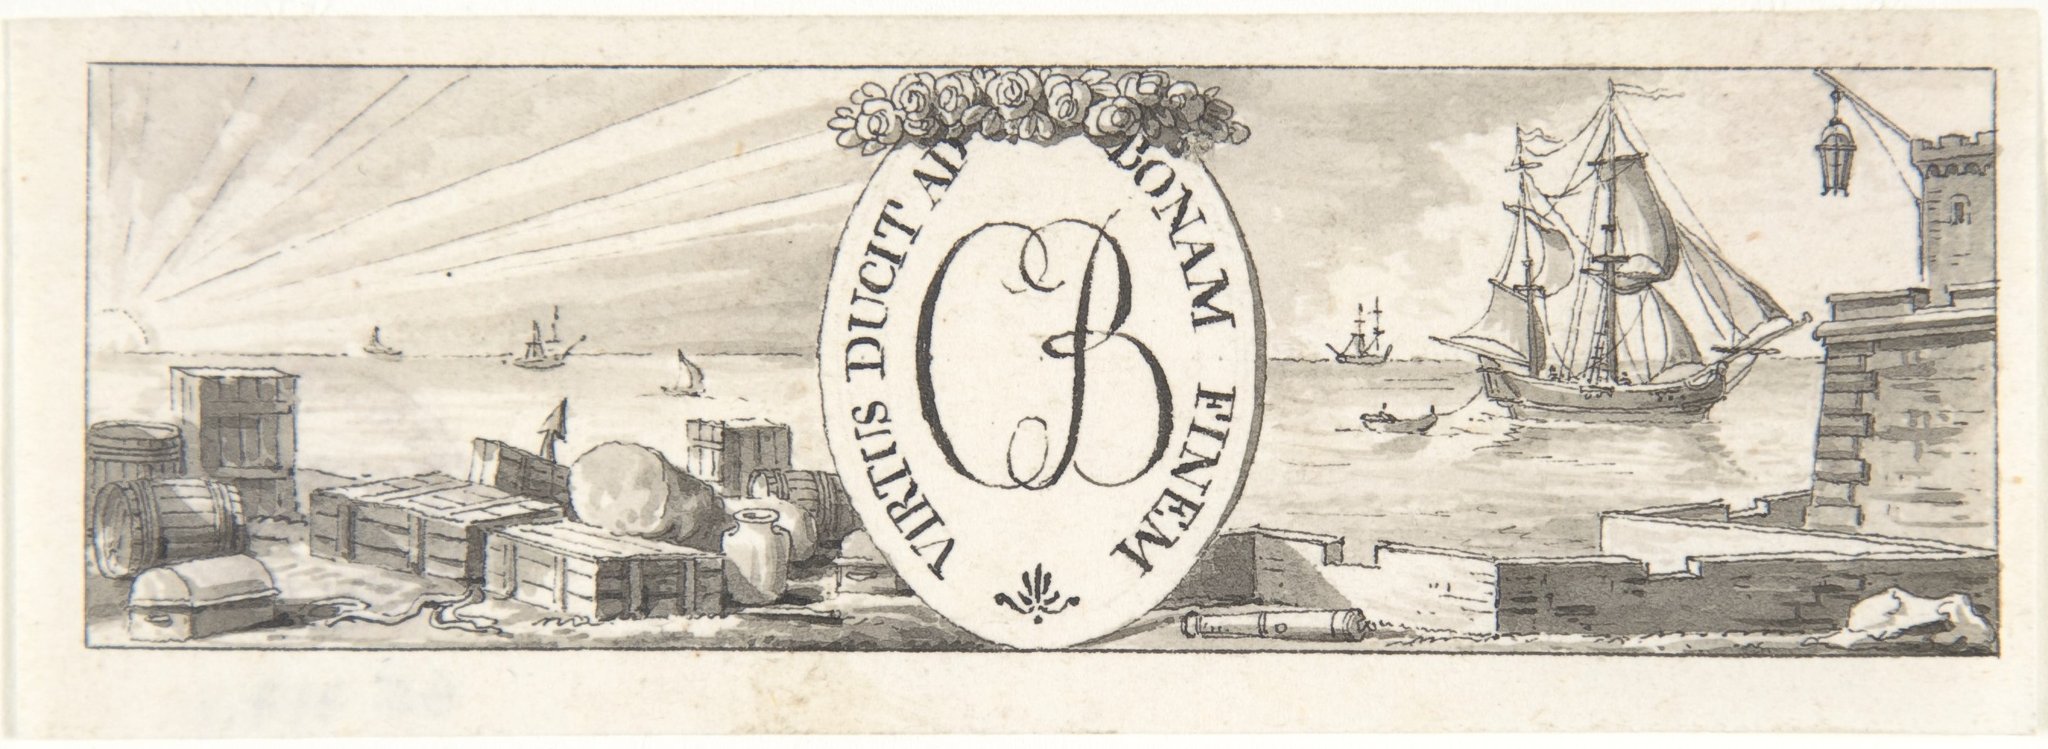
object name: drawing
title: Design for a Vignette: Harbor Scene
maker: charles percier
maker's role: designer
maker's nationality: french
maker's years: 1764-1838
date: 1764-1838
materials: ink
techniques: brush, pen, wash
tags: ships